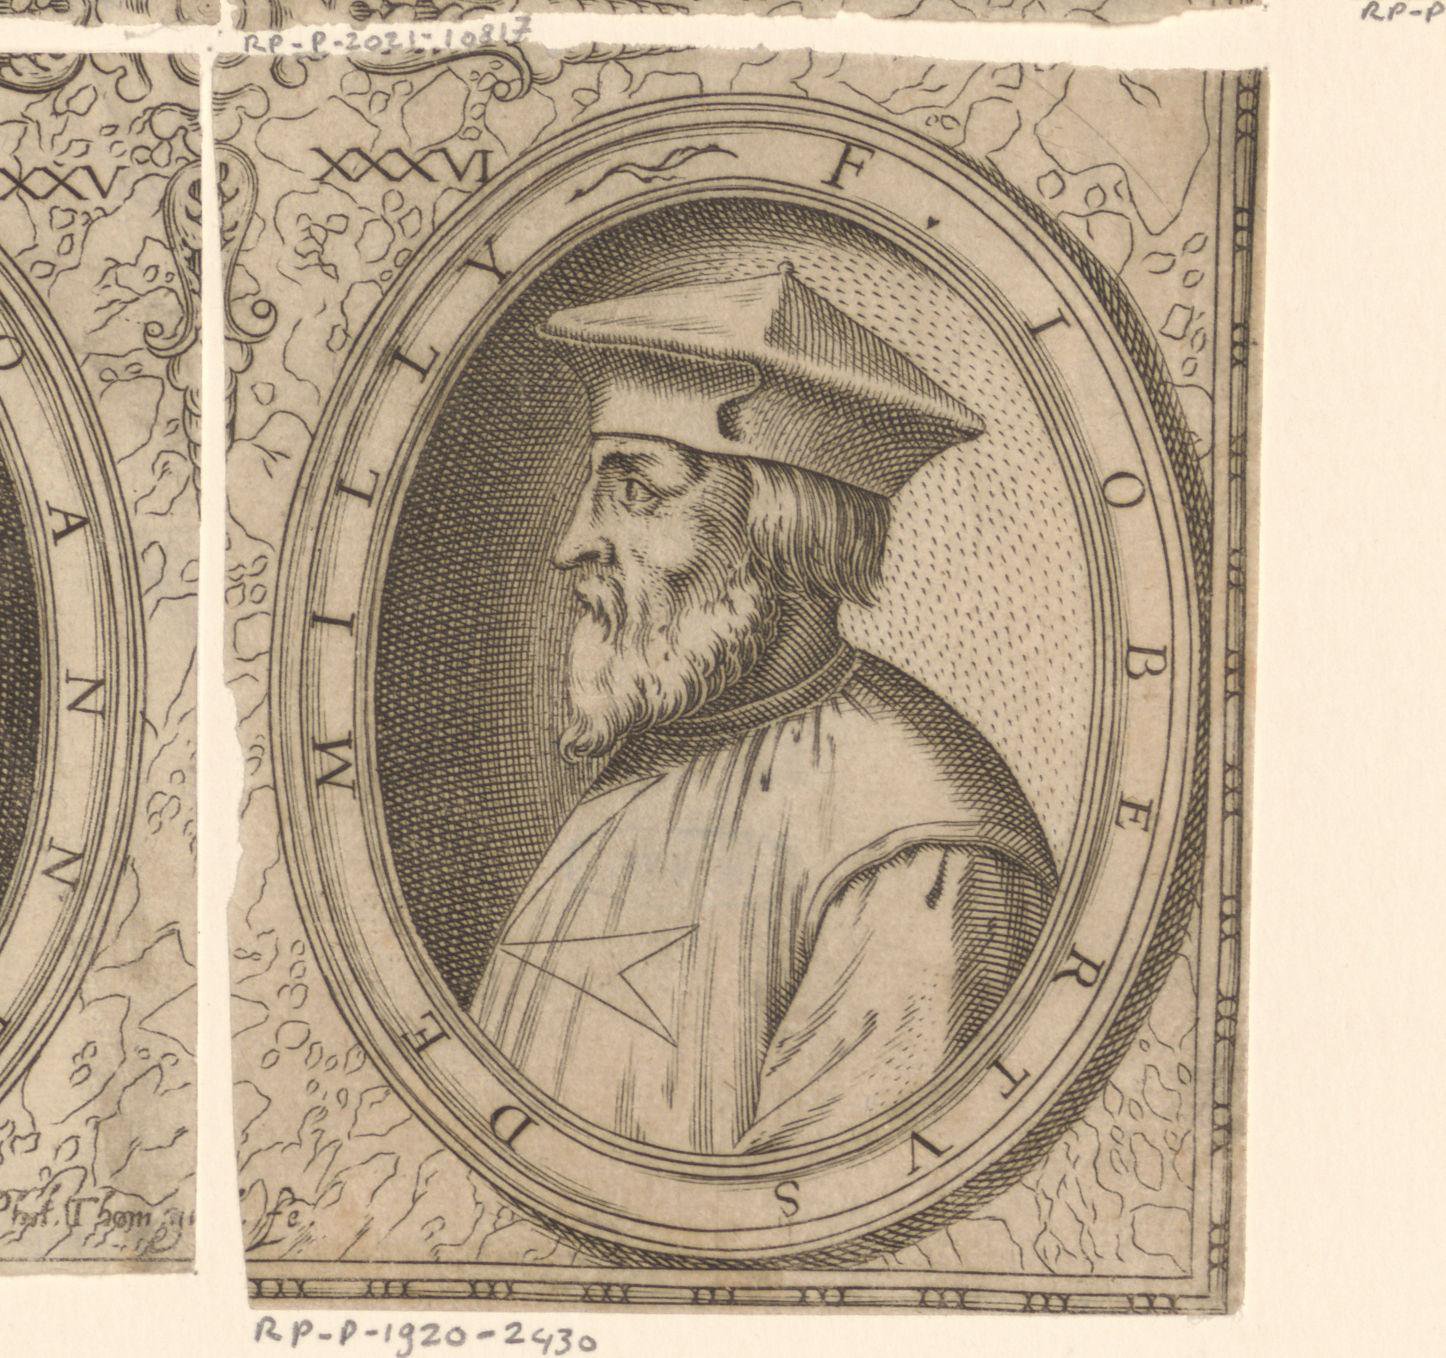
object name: print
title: Portret van Jacques de Milly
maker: philippe thomassin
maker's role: print maker, publisher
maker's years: 1562-1622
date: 1588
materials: paper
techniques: engraving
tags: historical persons, military orders, e.g.: knights templars, knights of malta, teutonic knights ~ roman catholic church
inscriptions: collector's mark: Lugt 2228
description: Deze prent maakt deel uit van een grotere prent met vier portretten die later is verknipt. Prent waarschijnlijk uit: Veltroni, Tolomeo. Statuta hospitalis Hierusalem. [Rome: s.n., 1588].